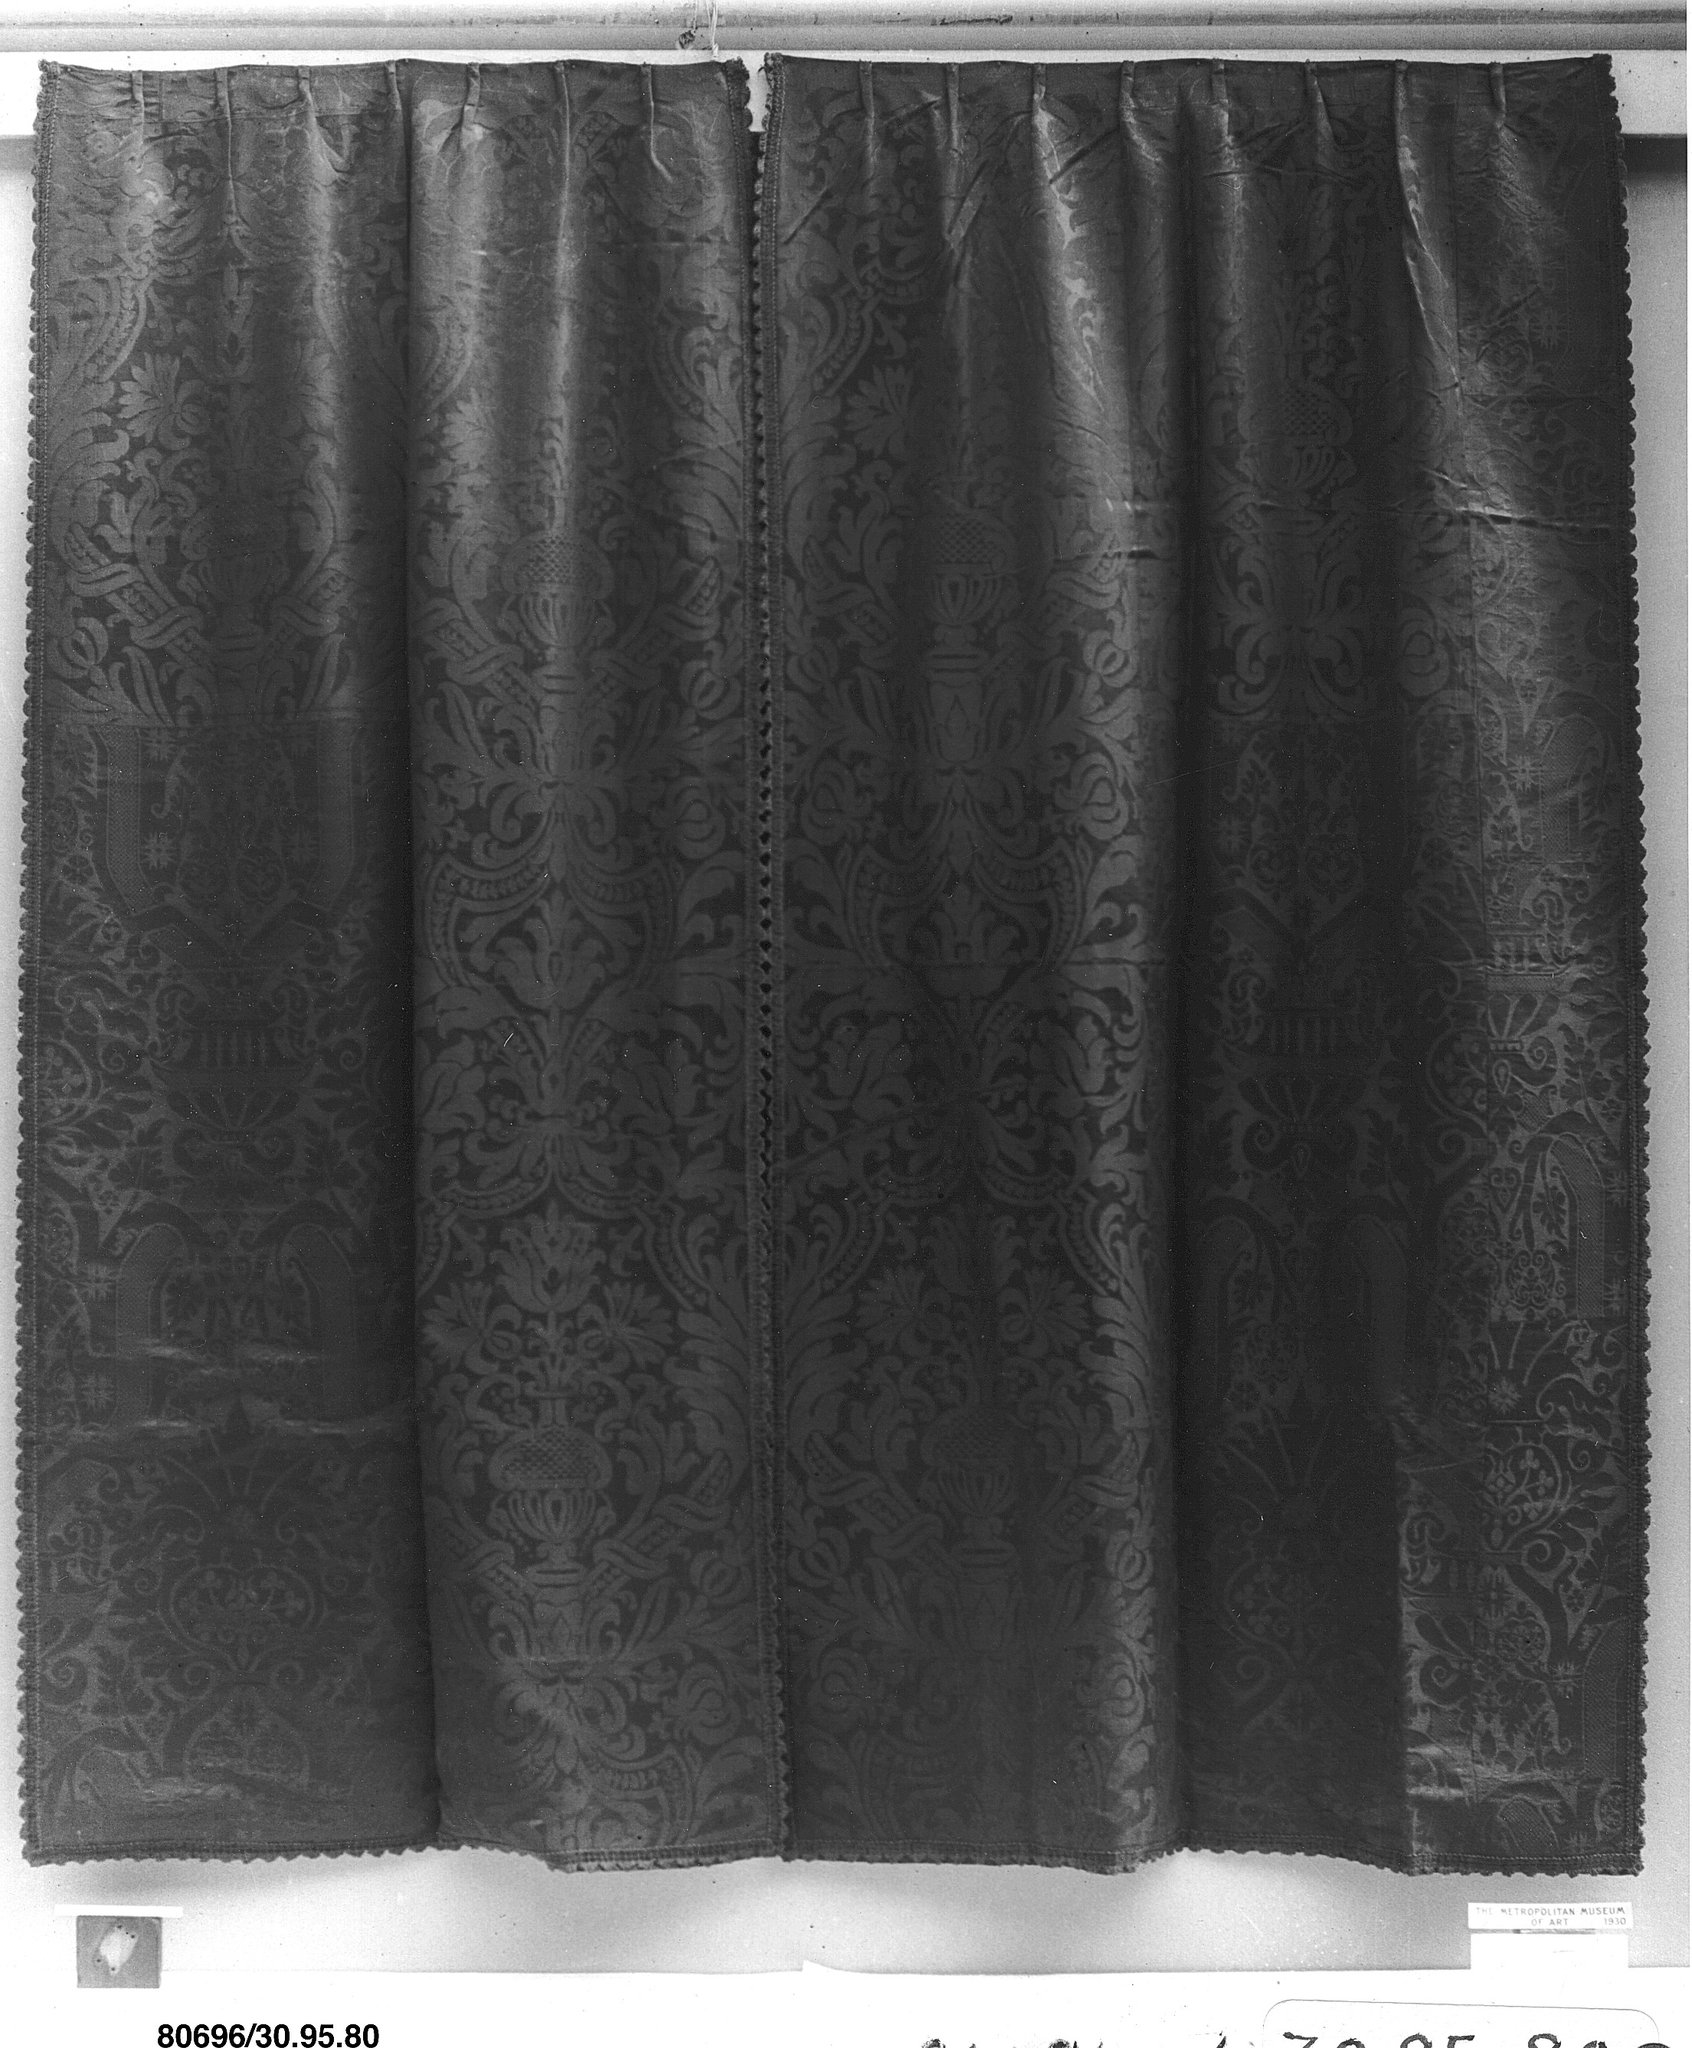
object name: piece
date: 1601-1700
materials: silk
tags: flowers